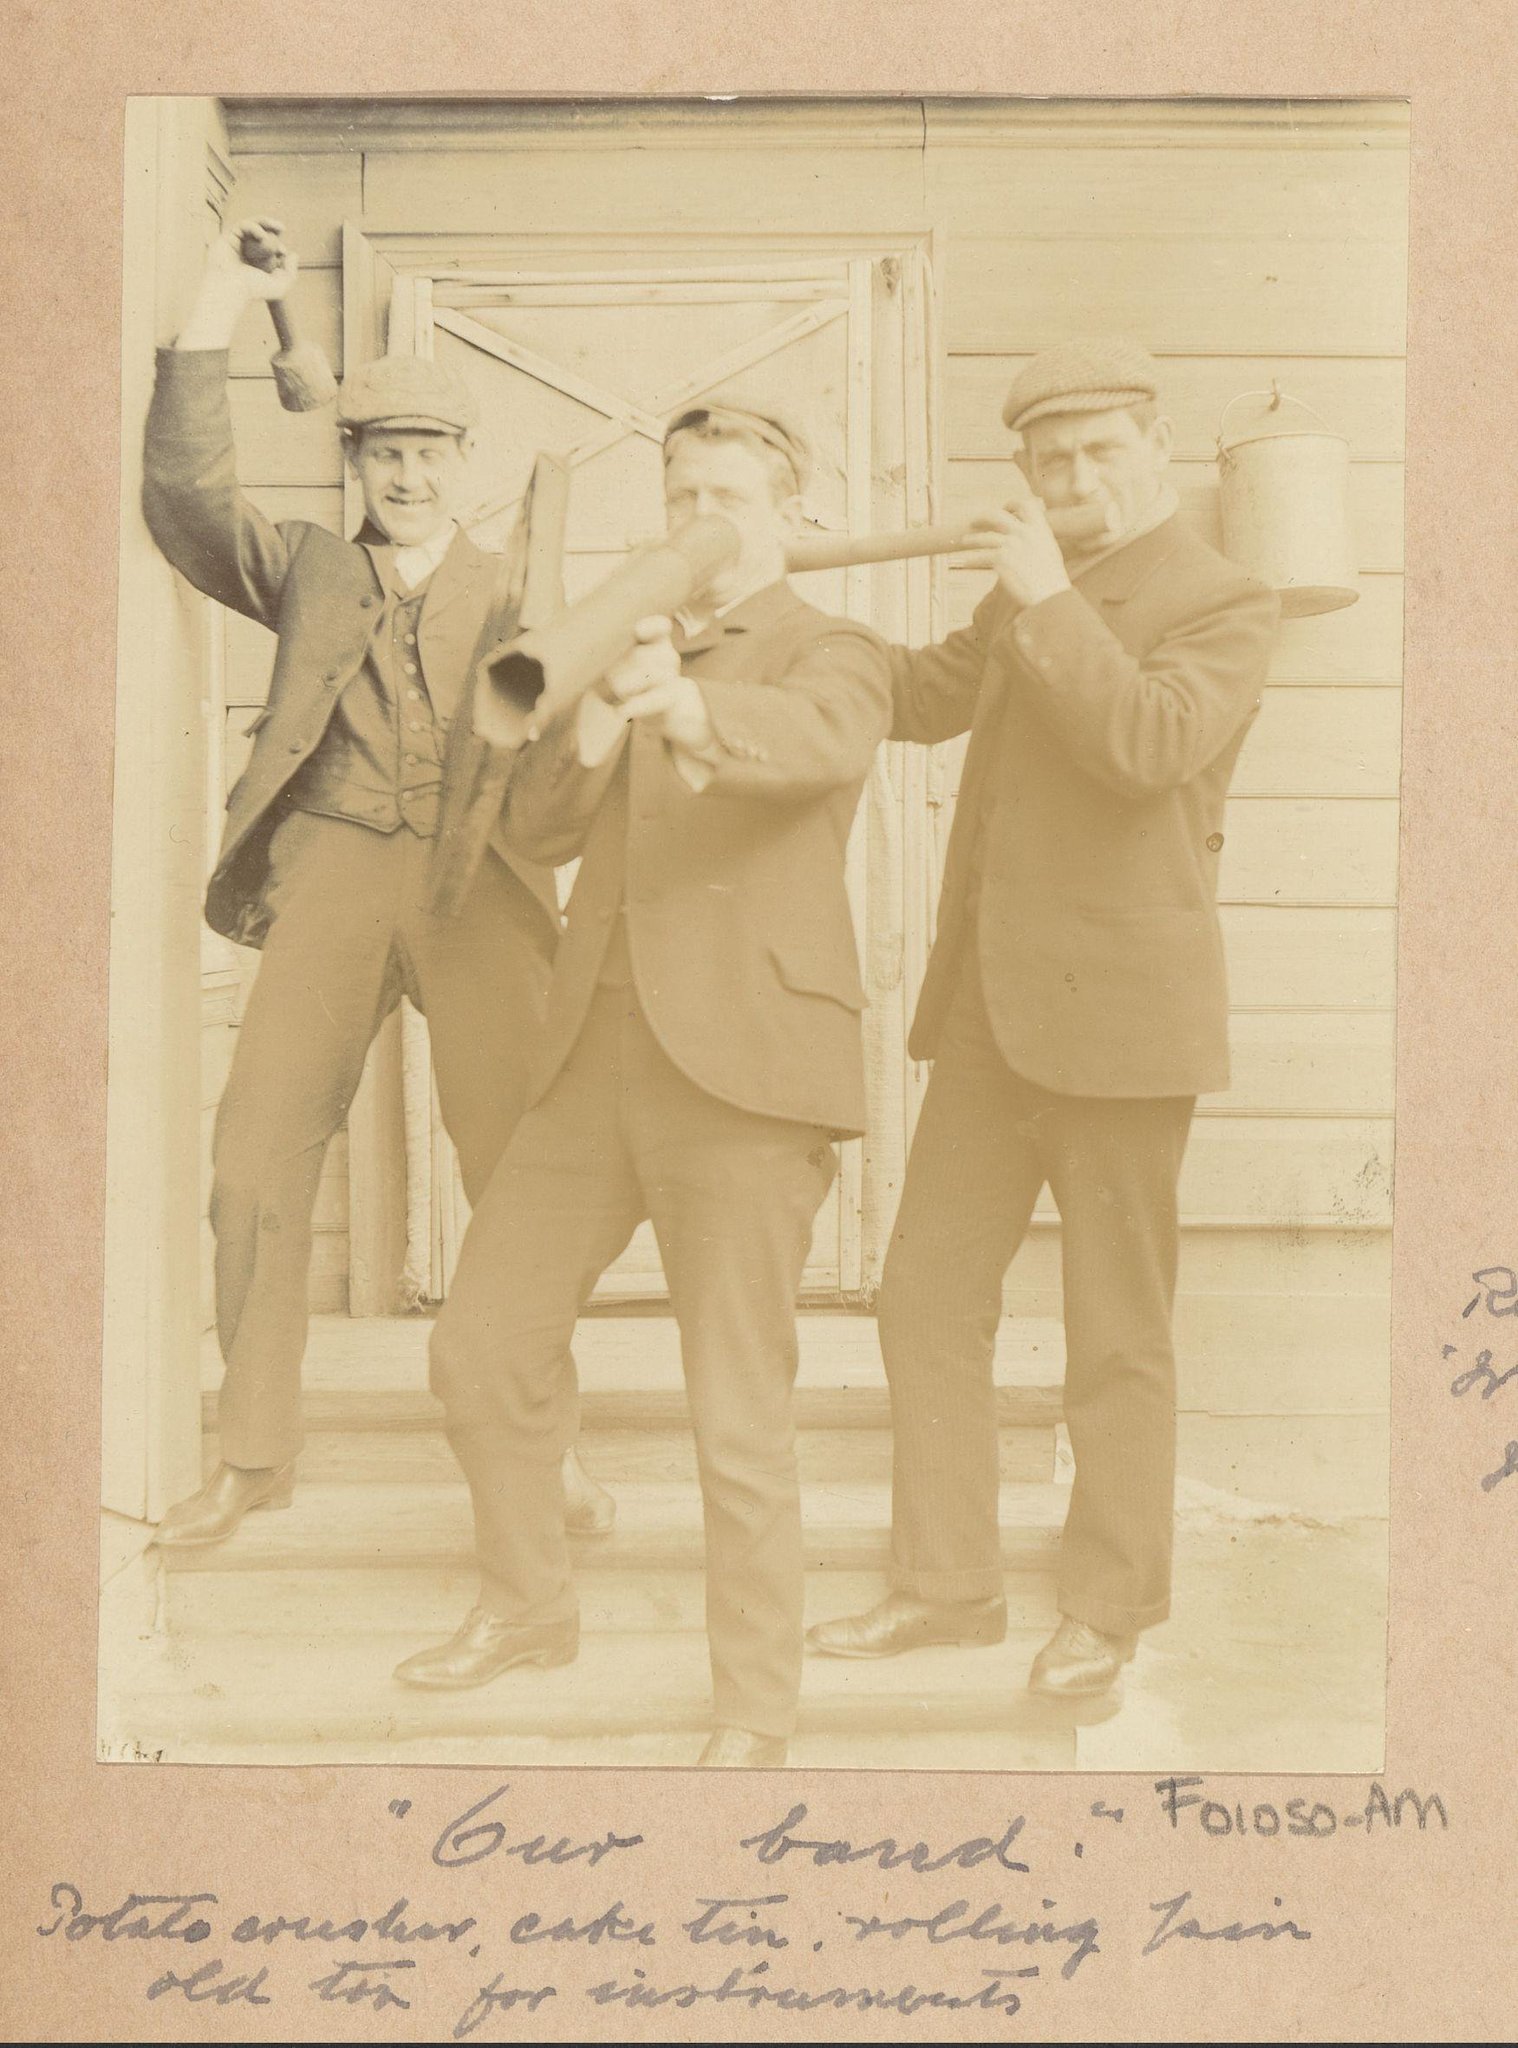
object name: photograph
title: Drie mannen maken 'muziek' op keukengerei in Rusland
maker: joseph cheetham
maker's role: engineer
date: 1903-1904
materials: photographic support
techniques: gelatin silver print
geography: russia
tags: kitchen-utensils, adult man, russia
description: Vermoedelijk betreft het hier Engelse vrienden van Joseph Cheetham. Vergelijk foto RP-F-F01050-W. Fotoalbum van de Engelse familie Cheetham met opnames van hun verblijf in Rusland.